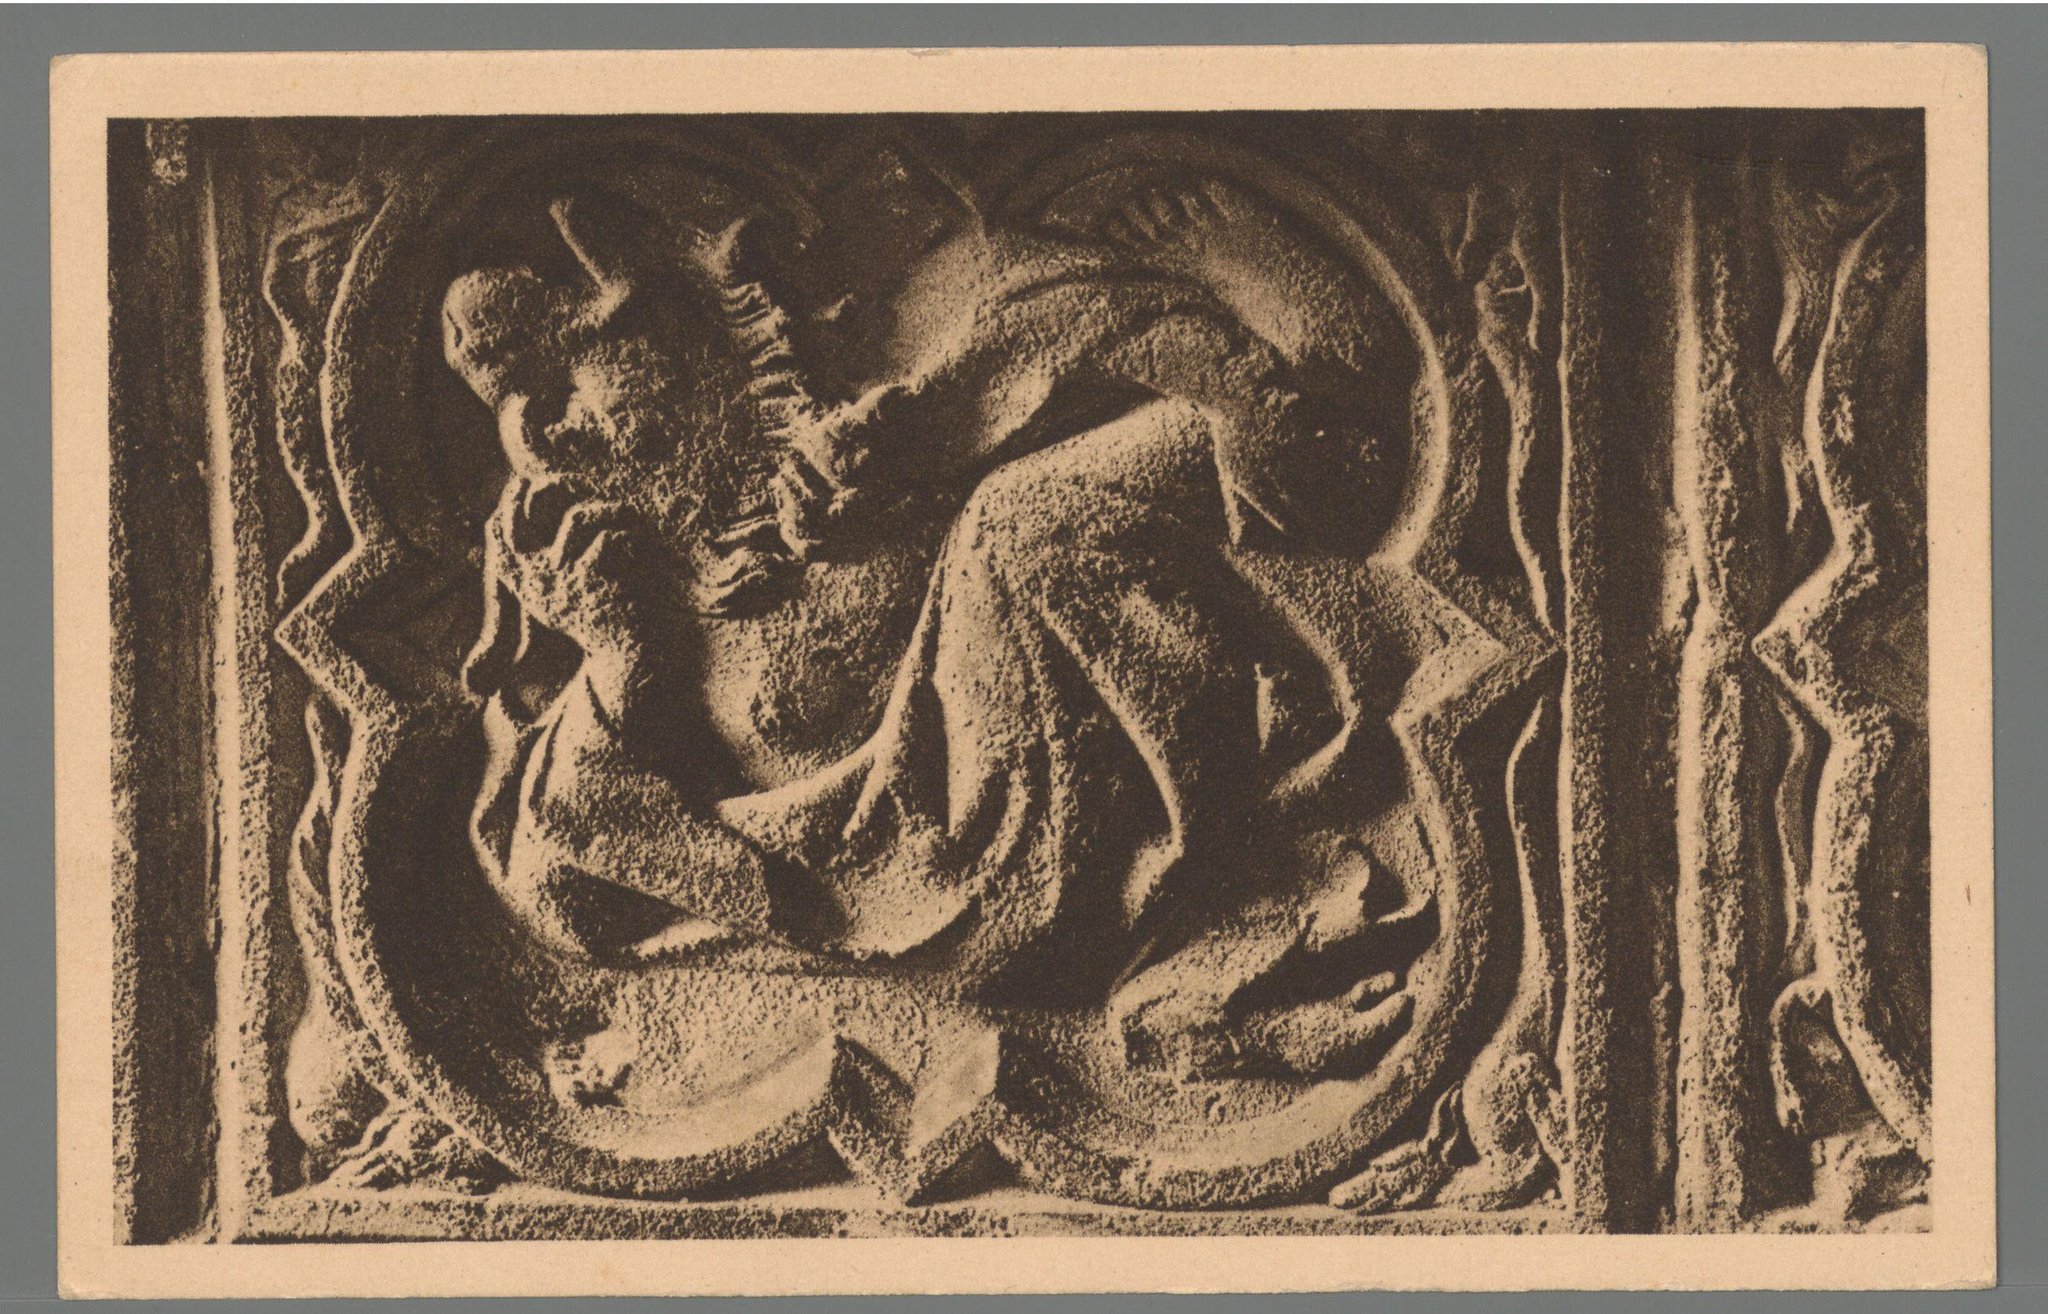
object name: ansichtkaart, prentbriefkaart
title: Cathédrale de Rouen. Les bas reliefs du Portail des Libraires (...)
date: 1920-1932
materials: cardboard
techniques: photograph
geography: rouen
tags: parts of church exterior and annexes: portal, sculpture